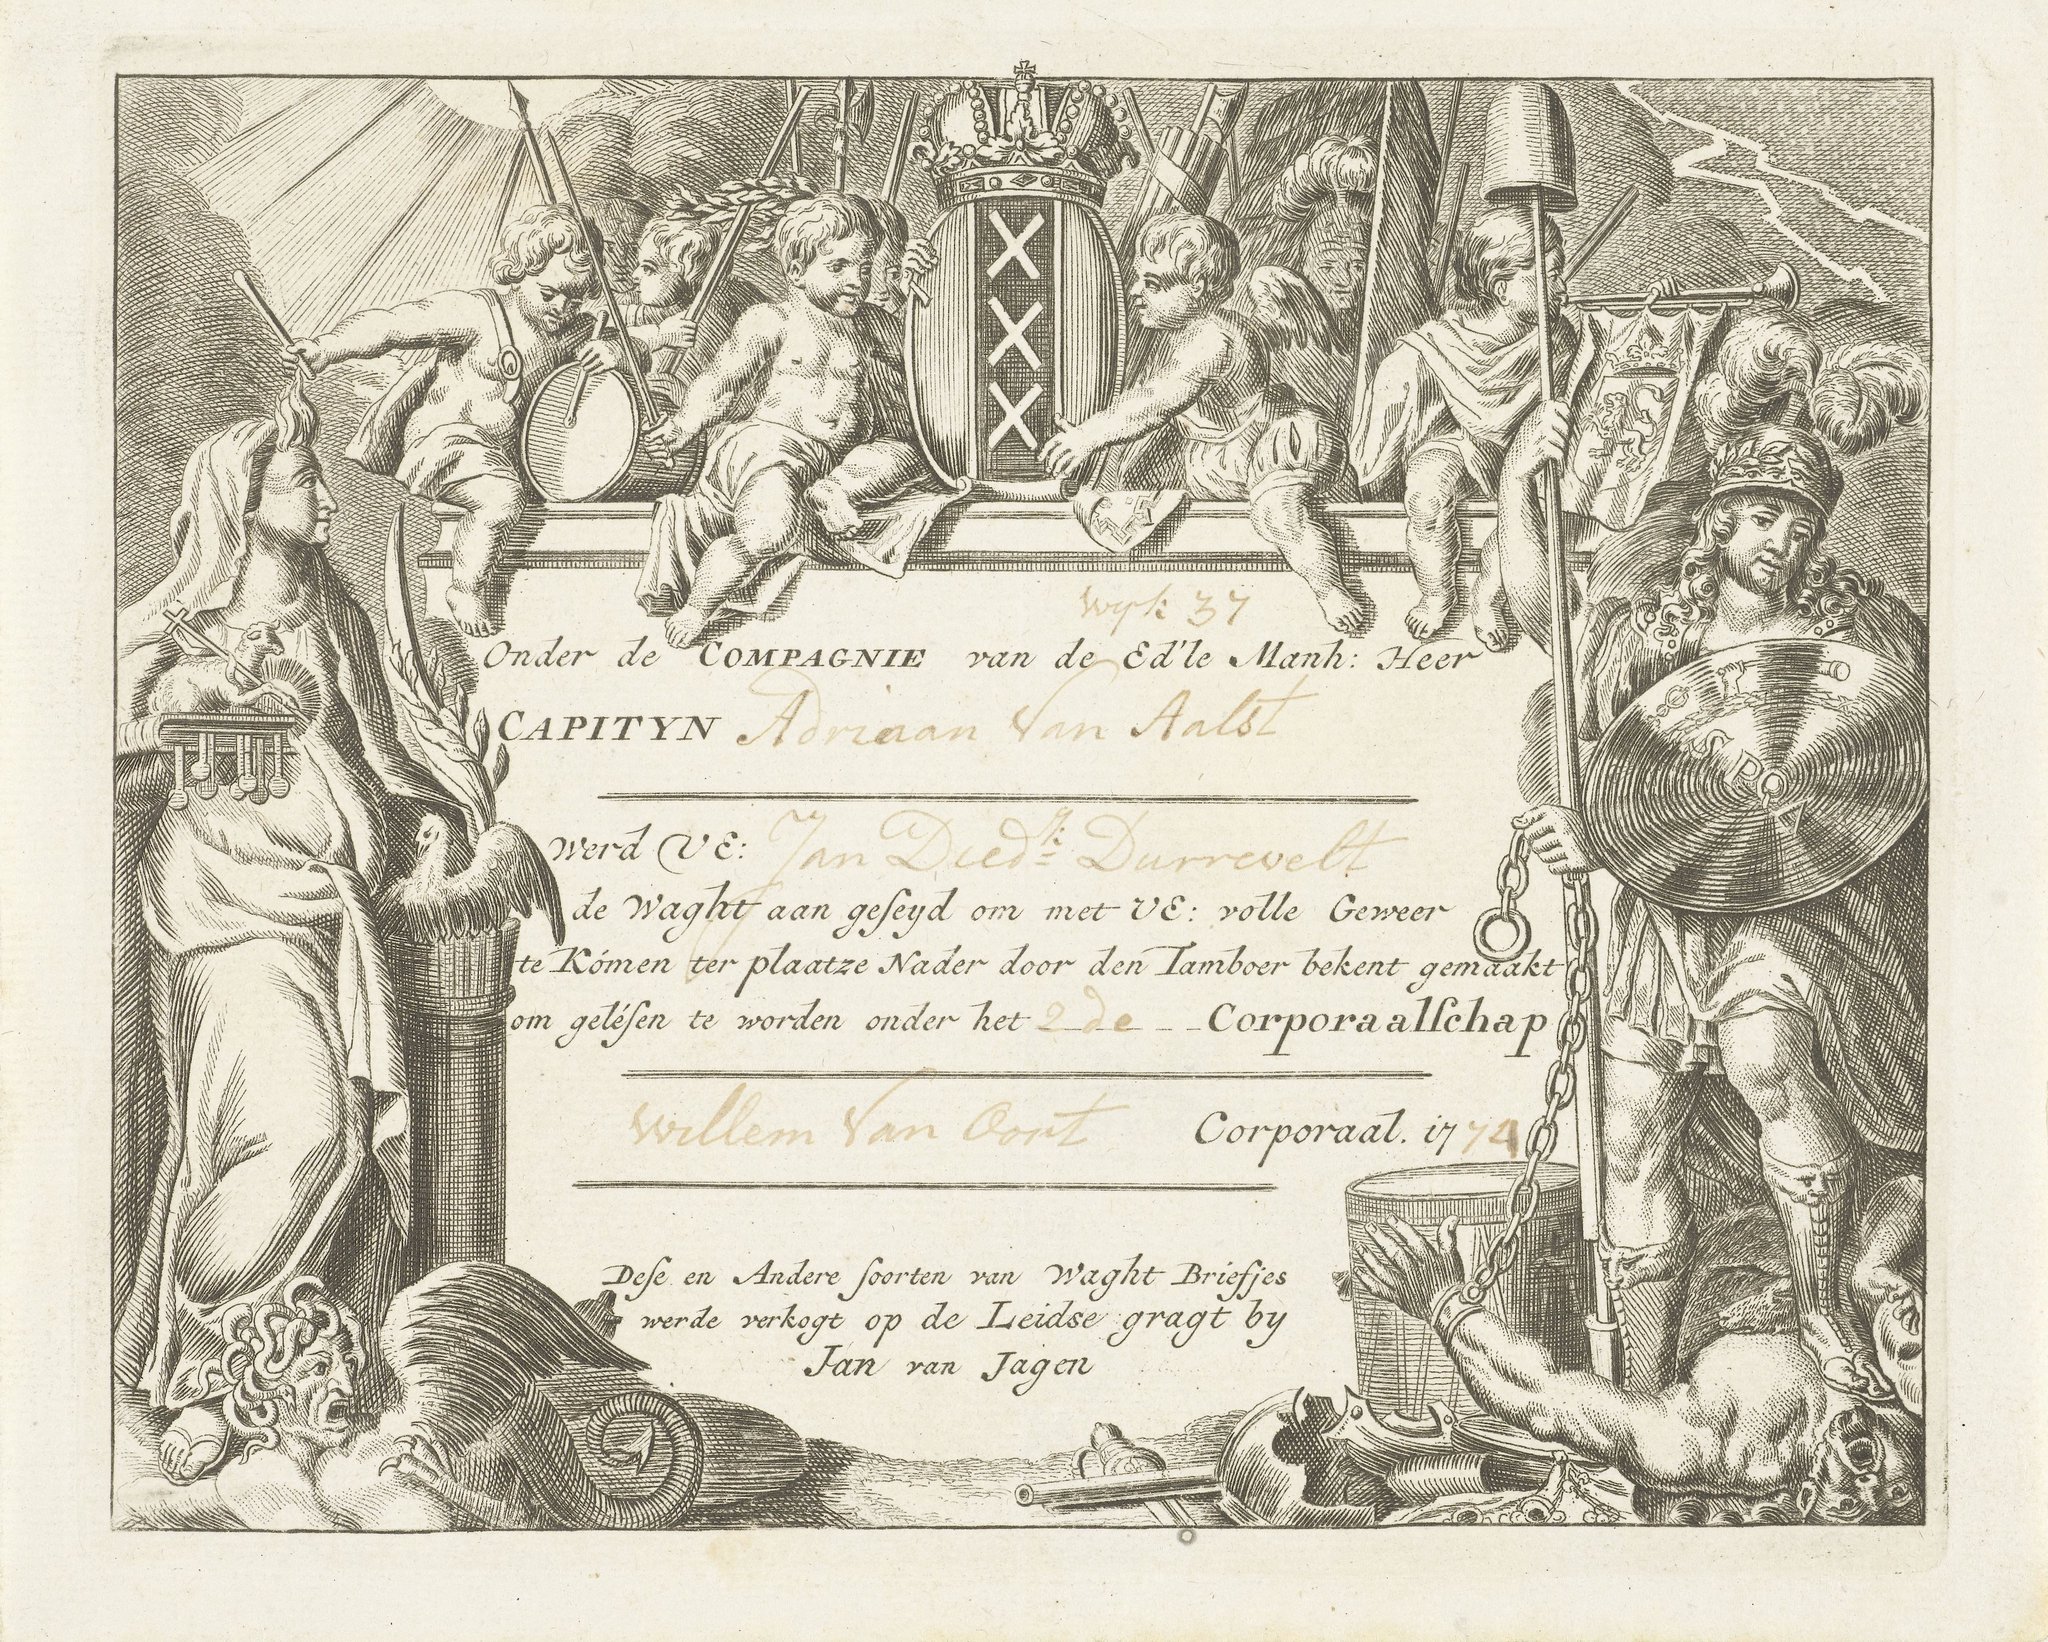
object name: print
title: Schuttersbrief van Amsterdam ten name van kapitein Adriaan van Aalst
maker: jan van jagen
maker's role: print maker, publisher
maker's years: 1709-1800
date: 1732-1800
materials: paper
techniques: engraving, etching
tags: device (as symbol of the state, etc.) (+ city; municipal), abstract ideas and concepts (+ personification)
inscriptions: inscription: ‘Wijk 37; Adriaan van Aalst; Jan Diedk Durrevelt; 2de; Willem van Oort; 74’, collector's mark: Lugt 2228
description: Schuttersbrief met personificatie van de stedenmaagd van Amsterdam die een geketende gevangene vertrapt en personificatie van het geloof die de ketterij vertrapt. Bekroond door putti en het stadswapen van de stad Amsterdam.